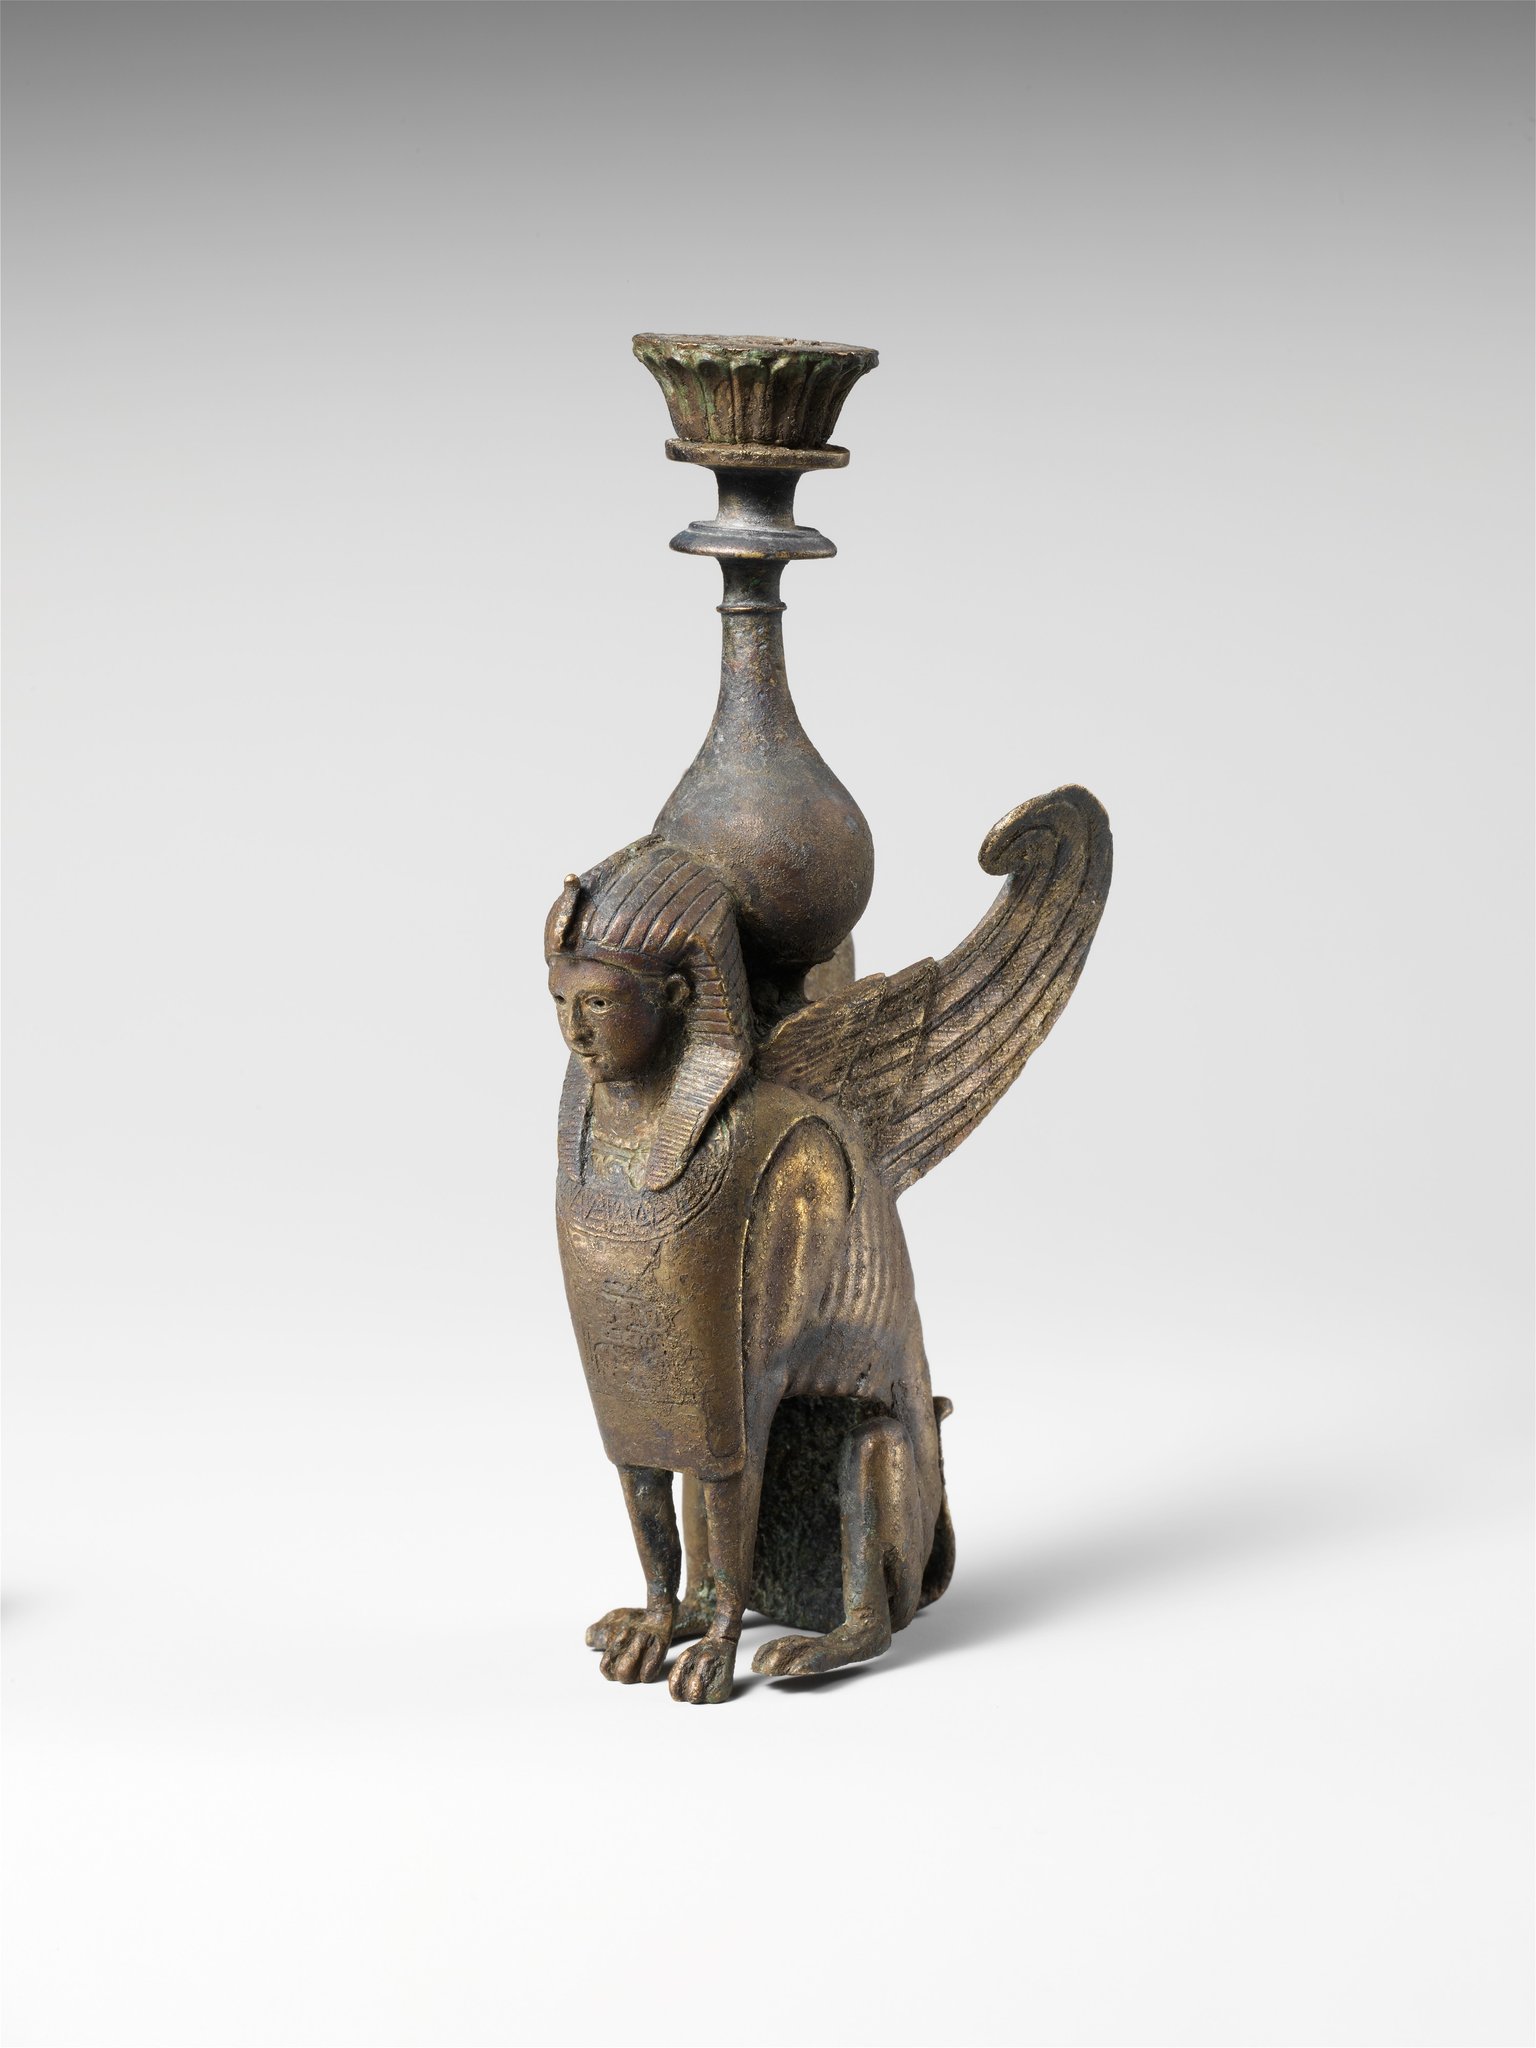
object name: ornament in the form of a seated male sphinx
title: Bronze ornament in the form of a seated male sphinx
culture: roman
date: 27 BCE-14 CE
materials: bronze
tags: sphinx